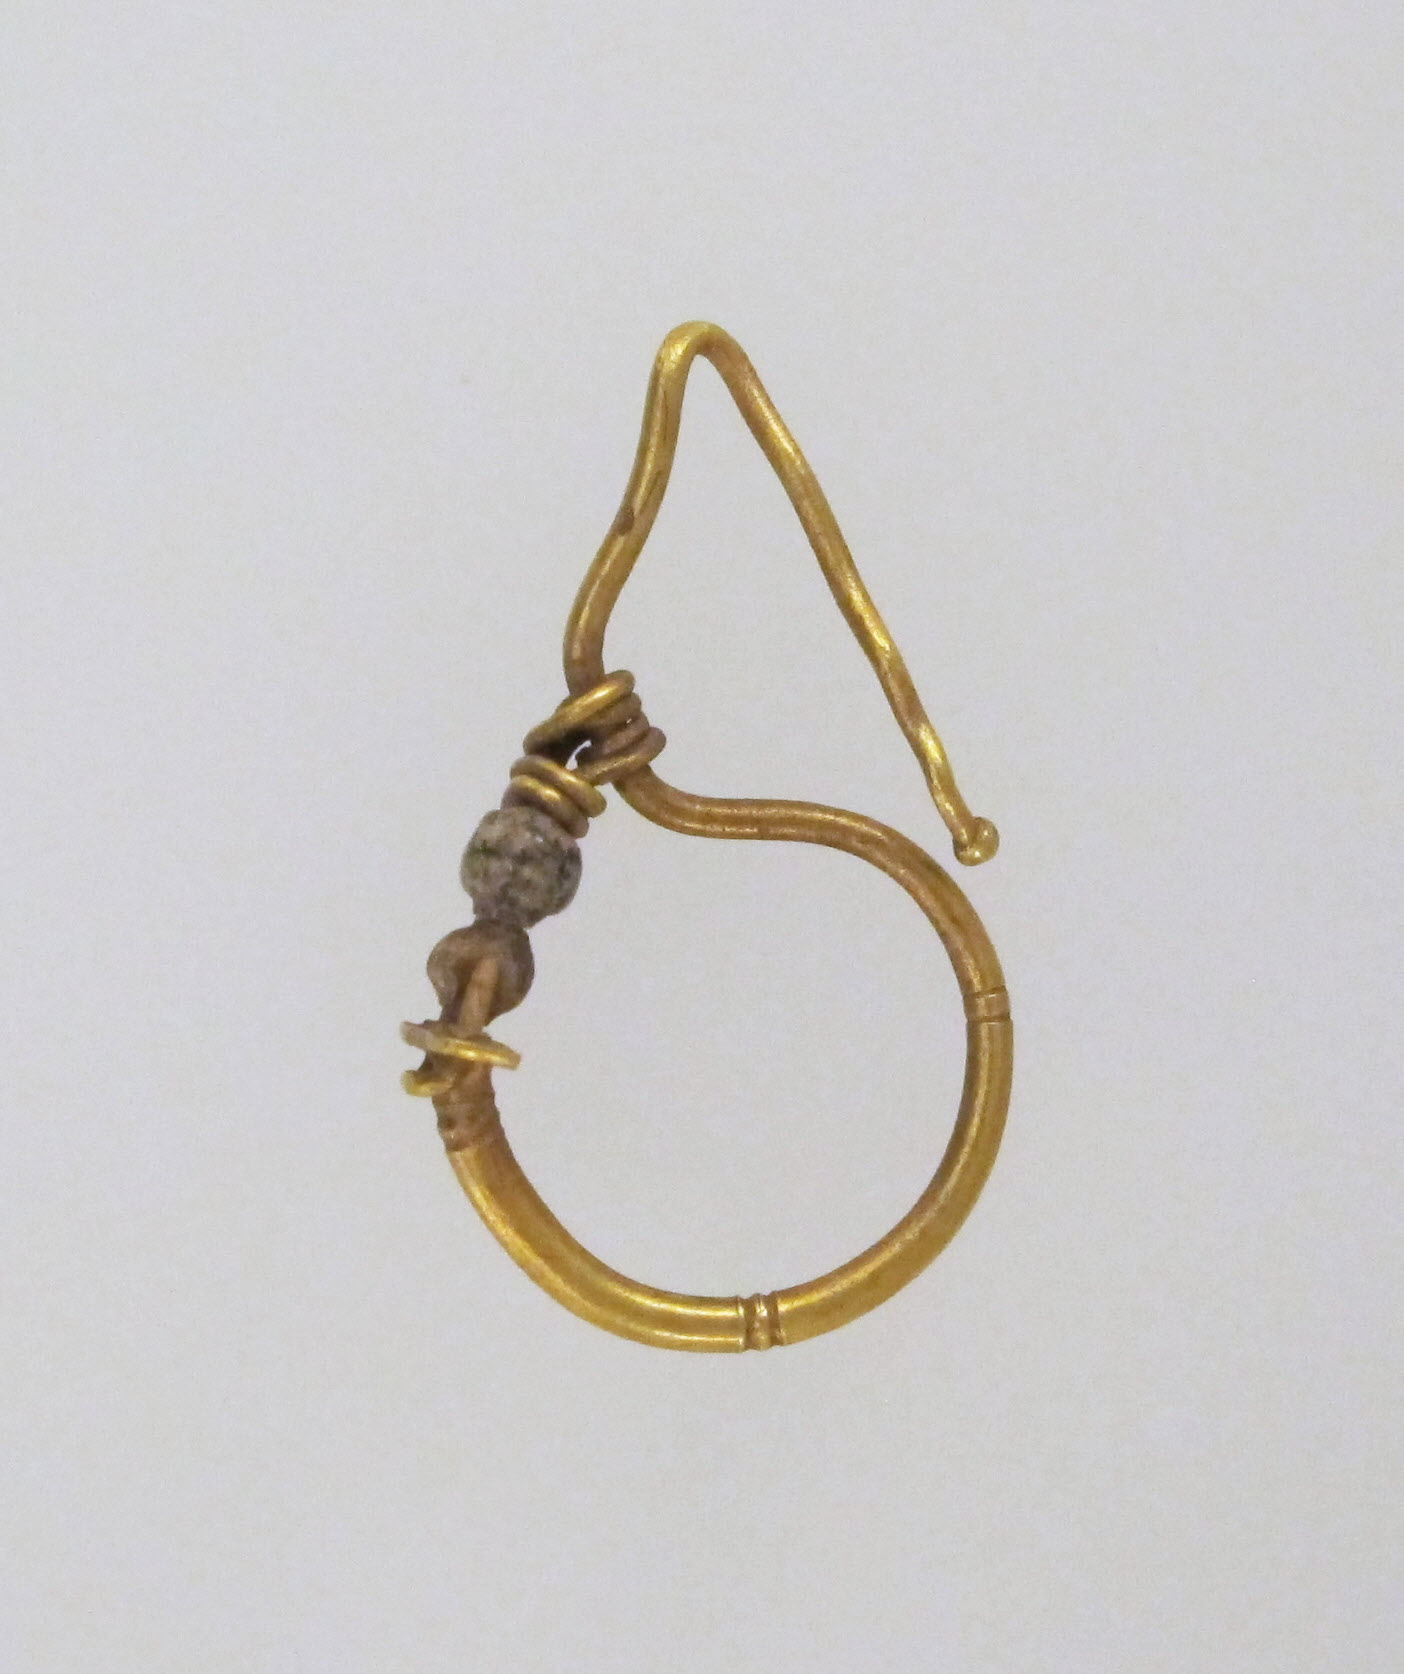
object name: earring, delta shaped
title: Earring, delta-shaped with beads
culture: roman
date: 1-100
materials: glass, gold